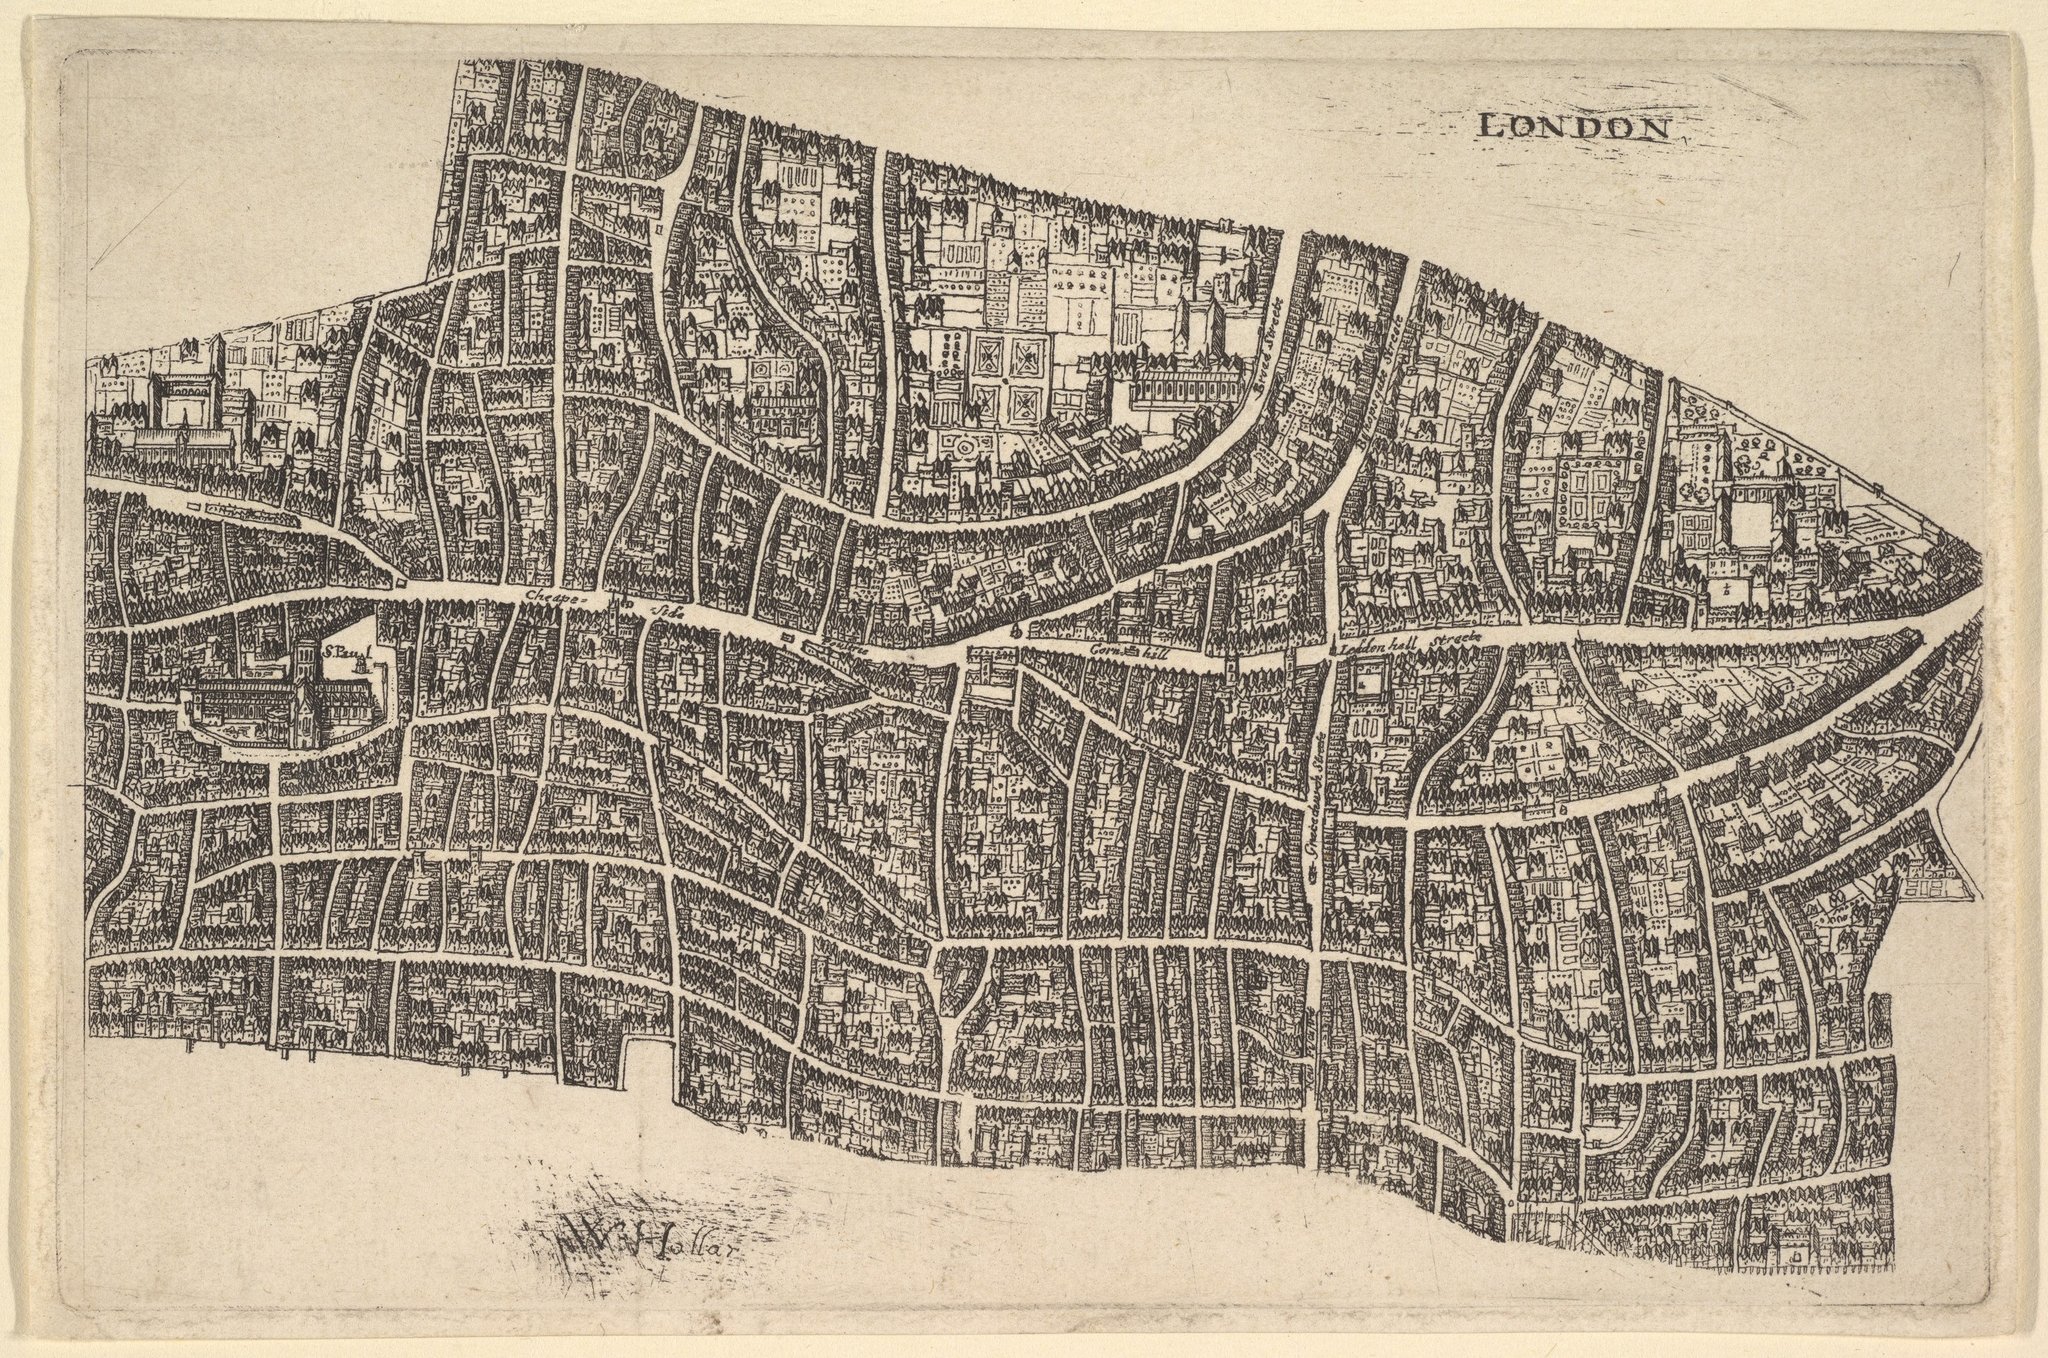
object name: print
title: London before the Great Fire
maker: wenceslaus hollar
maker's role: artist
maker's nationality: bohemian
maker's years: 1607-1677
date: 1666-1677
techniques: etching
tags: maps,london